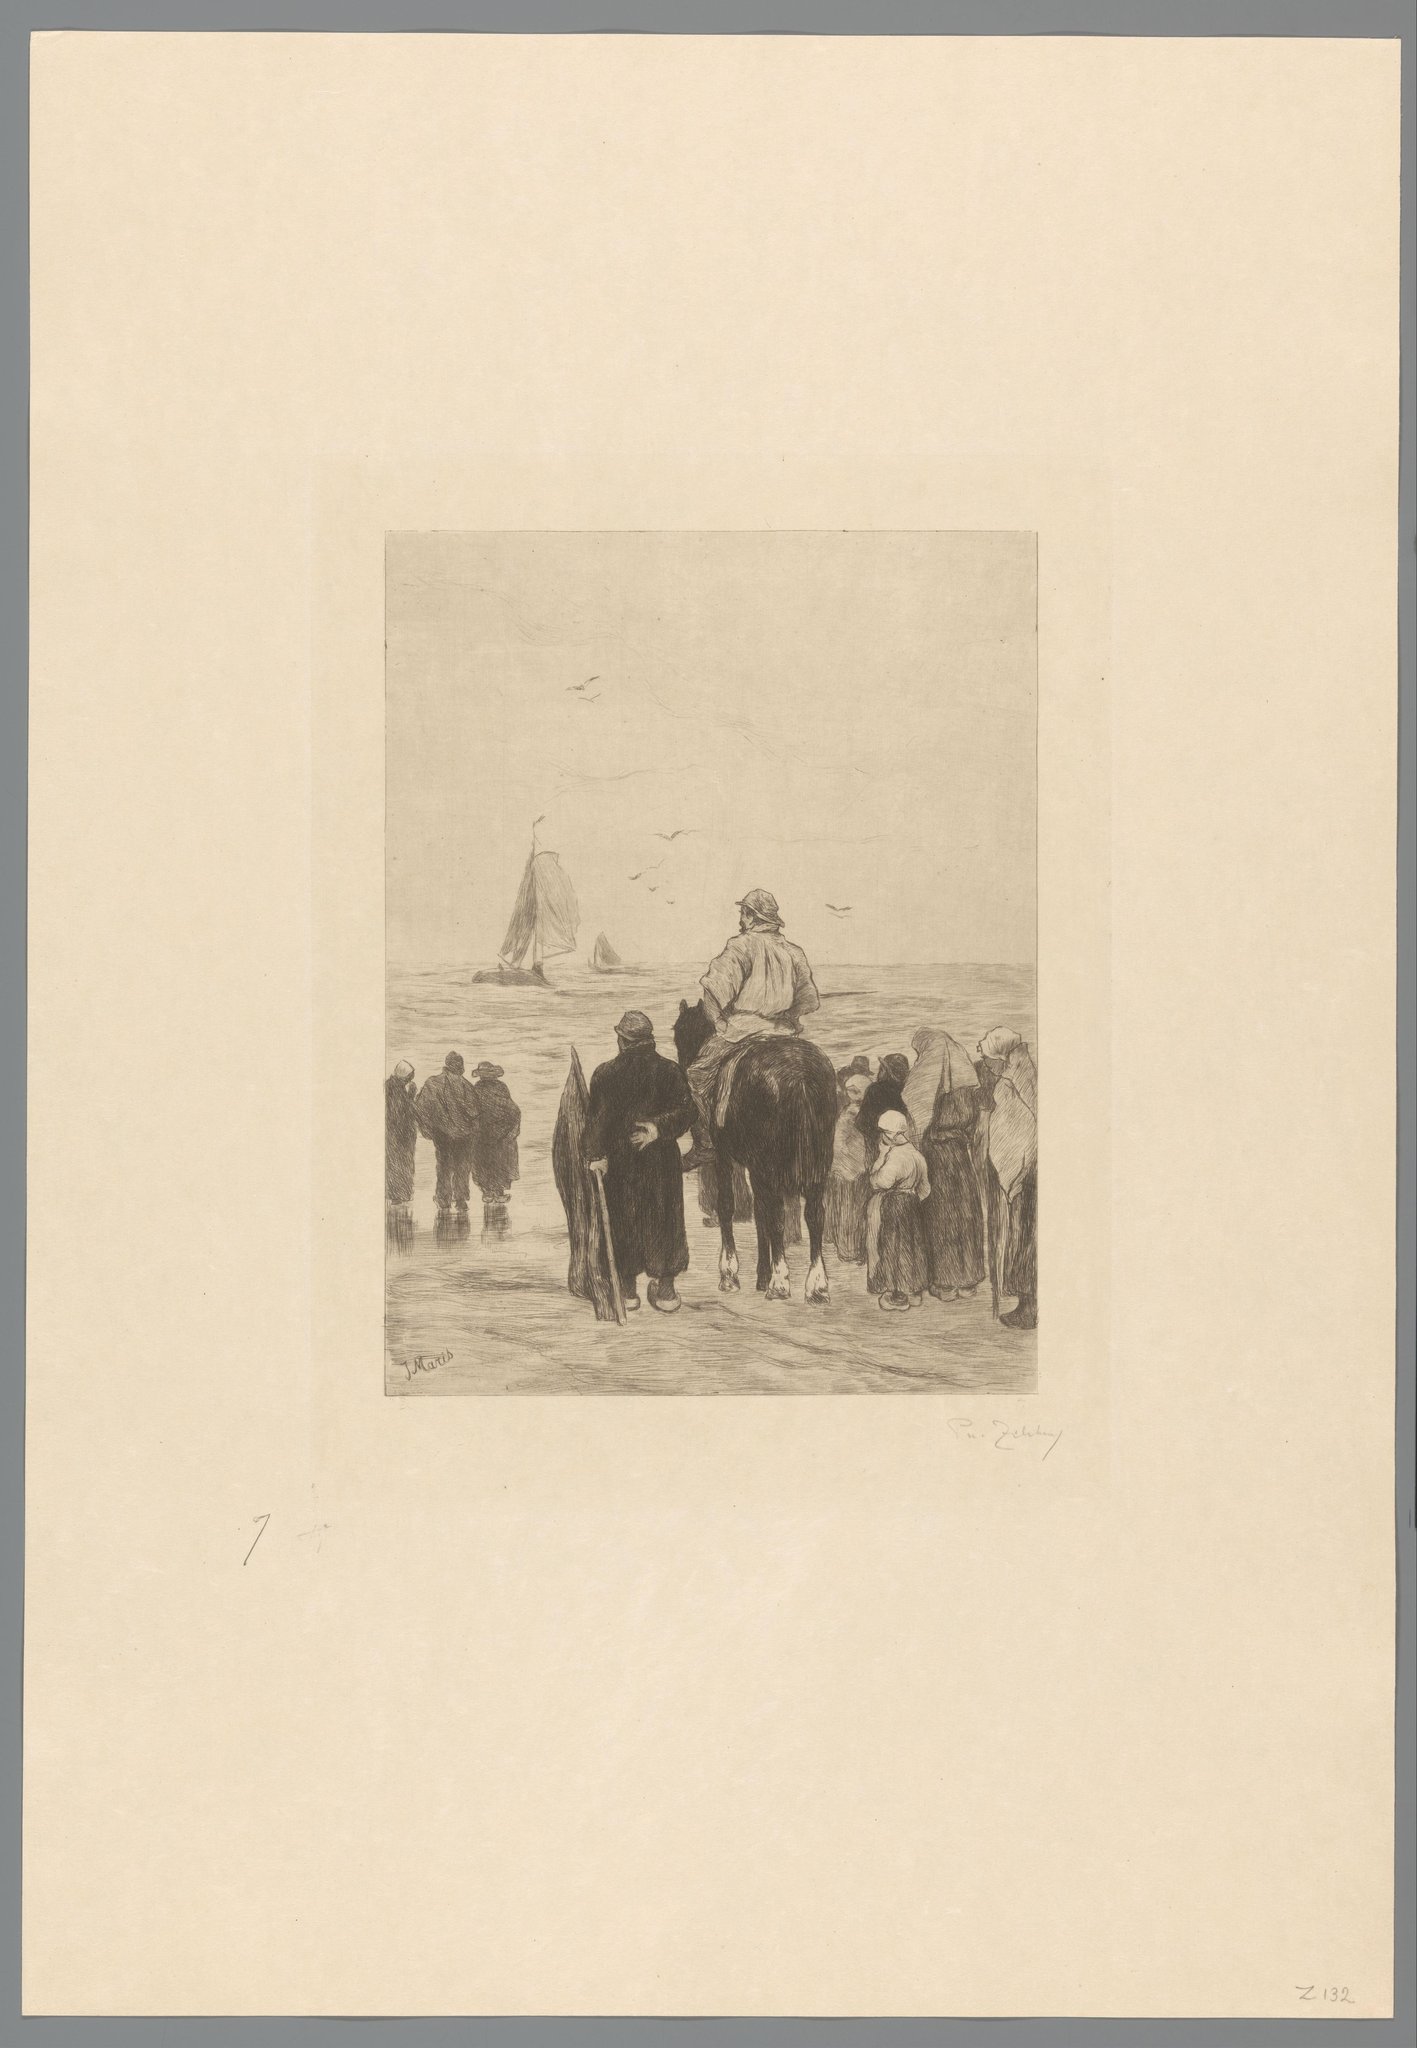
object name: print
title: Jacob Maris. Twelve Landscapes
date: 1888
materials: paper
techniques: drypoint, etching, intaglio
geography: amsterdam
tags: sailing-ship, sailing-boat, beach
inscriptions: collector's mark: Lugt 2228, number: ‘7’